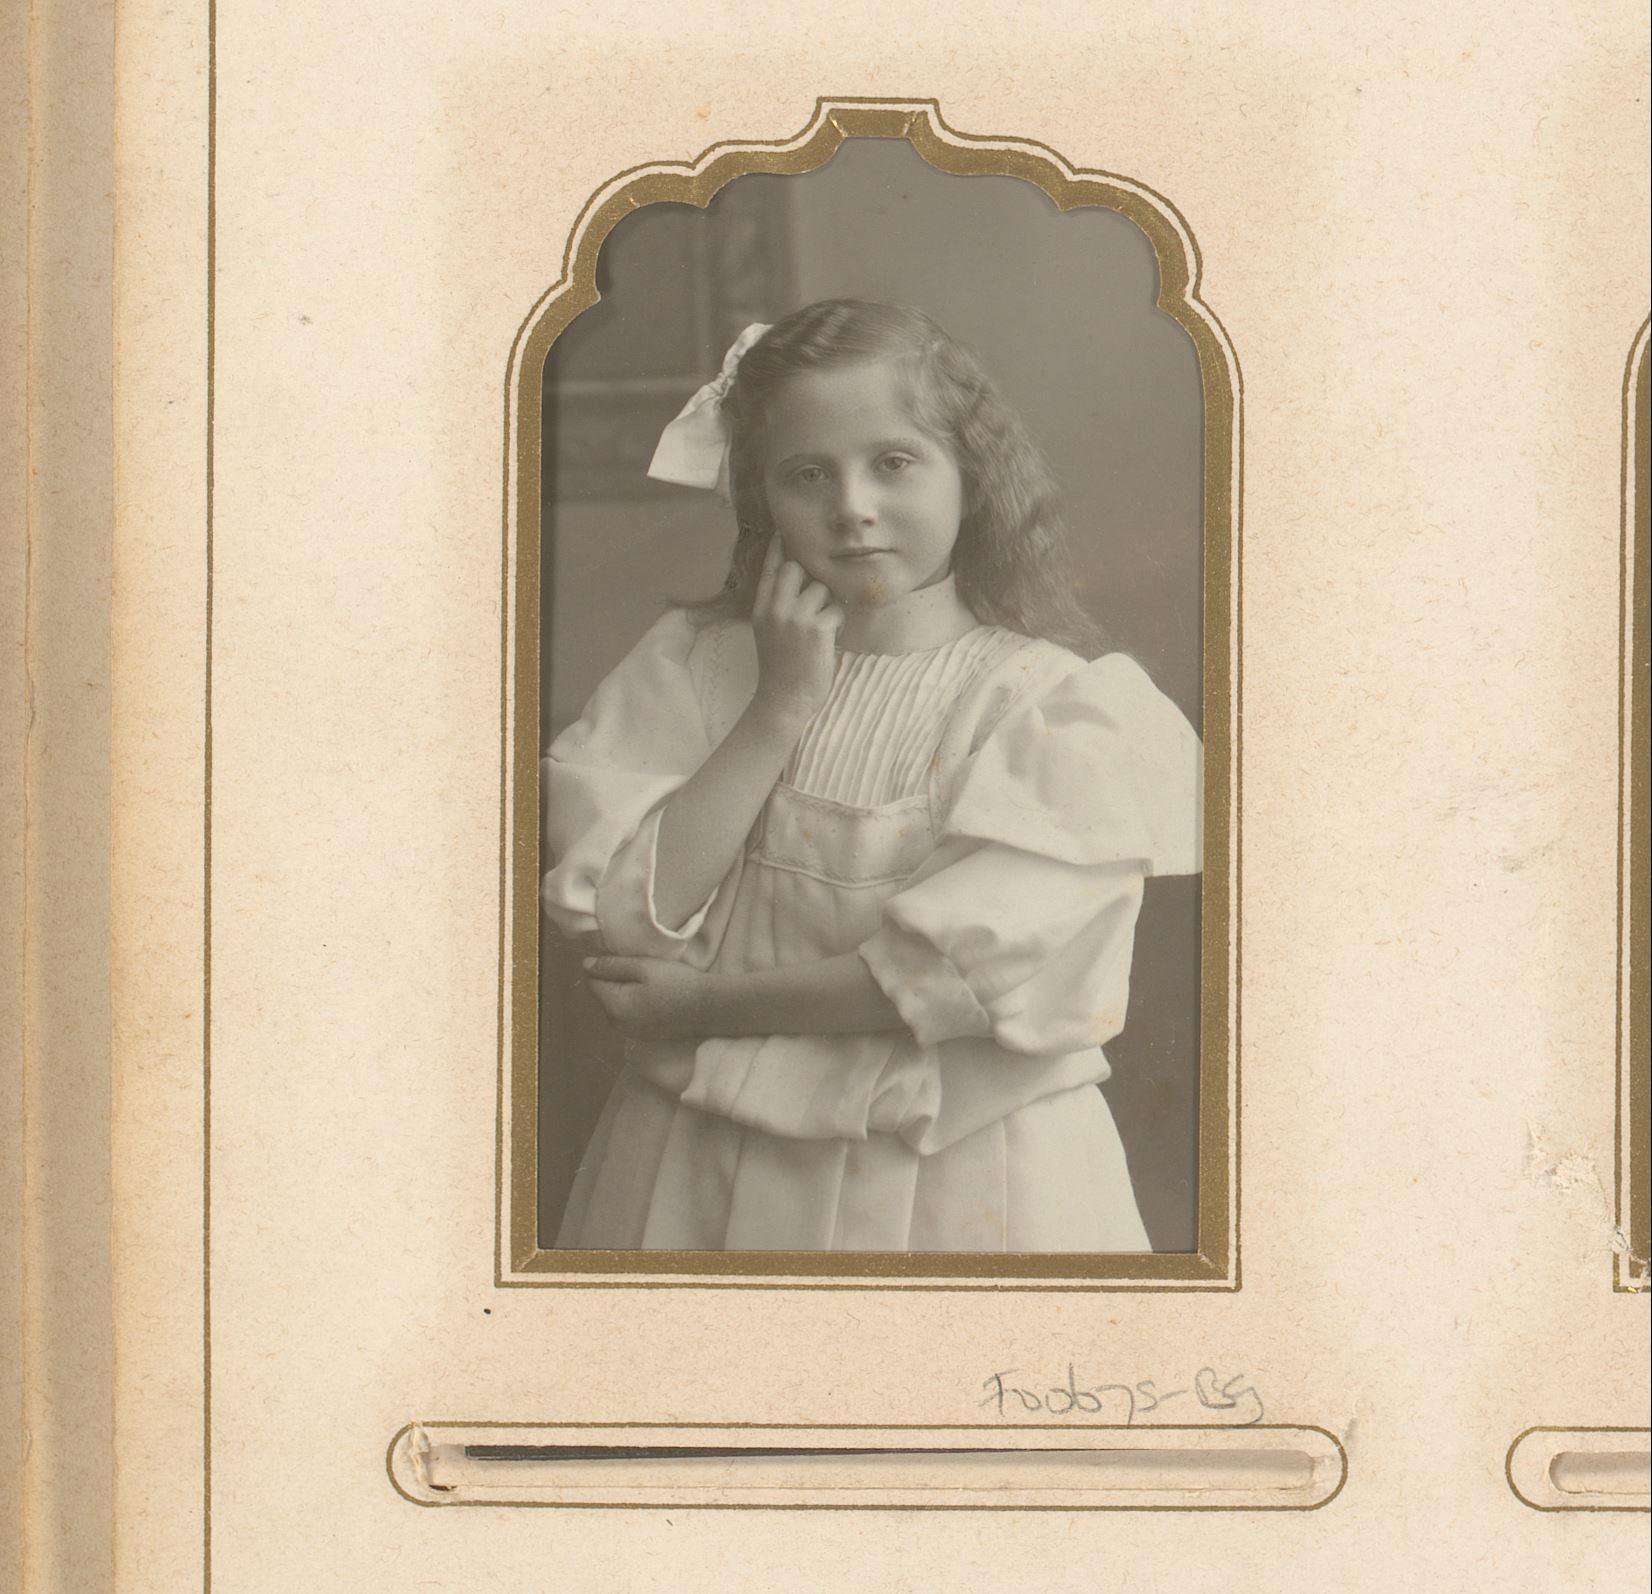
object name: carte de visite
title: Portret van een meisje in witte jurk met strik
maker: carl oppermann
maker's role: fotograaf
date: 1907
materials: cardboard, photographic support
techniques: gelatin silver print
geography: mönchengladbach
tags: girl (child between toddler and youth)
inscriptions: inscription: ‘Carl Opperman/ Photogr. Atelier/ M. Gladbach/ Bahnhofstrasse 18.’, annotation: ‘[Louisa Thalia ... geb. 19 Dezember/ 1900/ 7 1/2 J./ alt]’